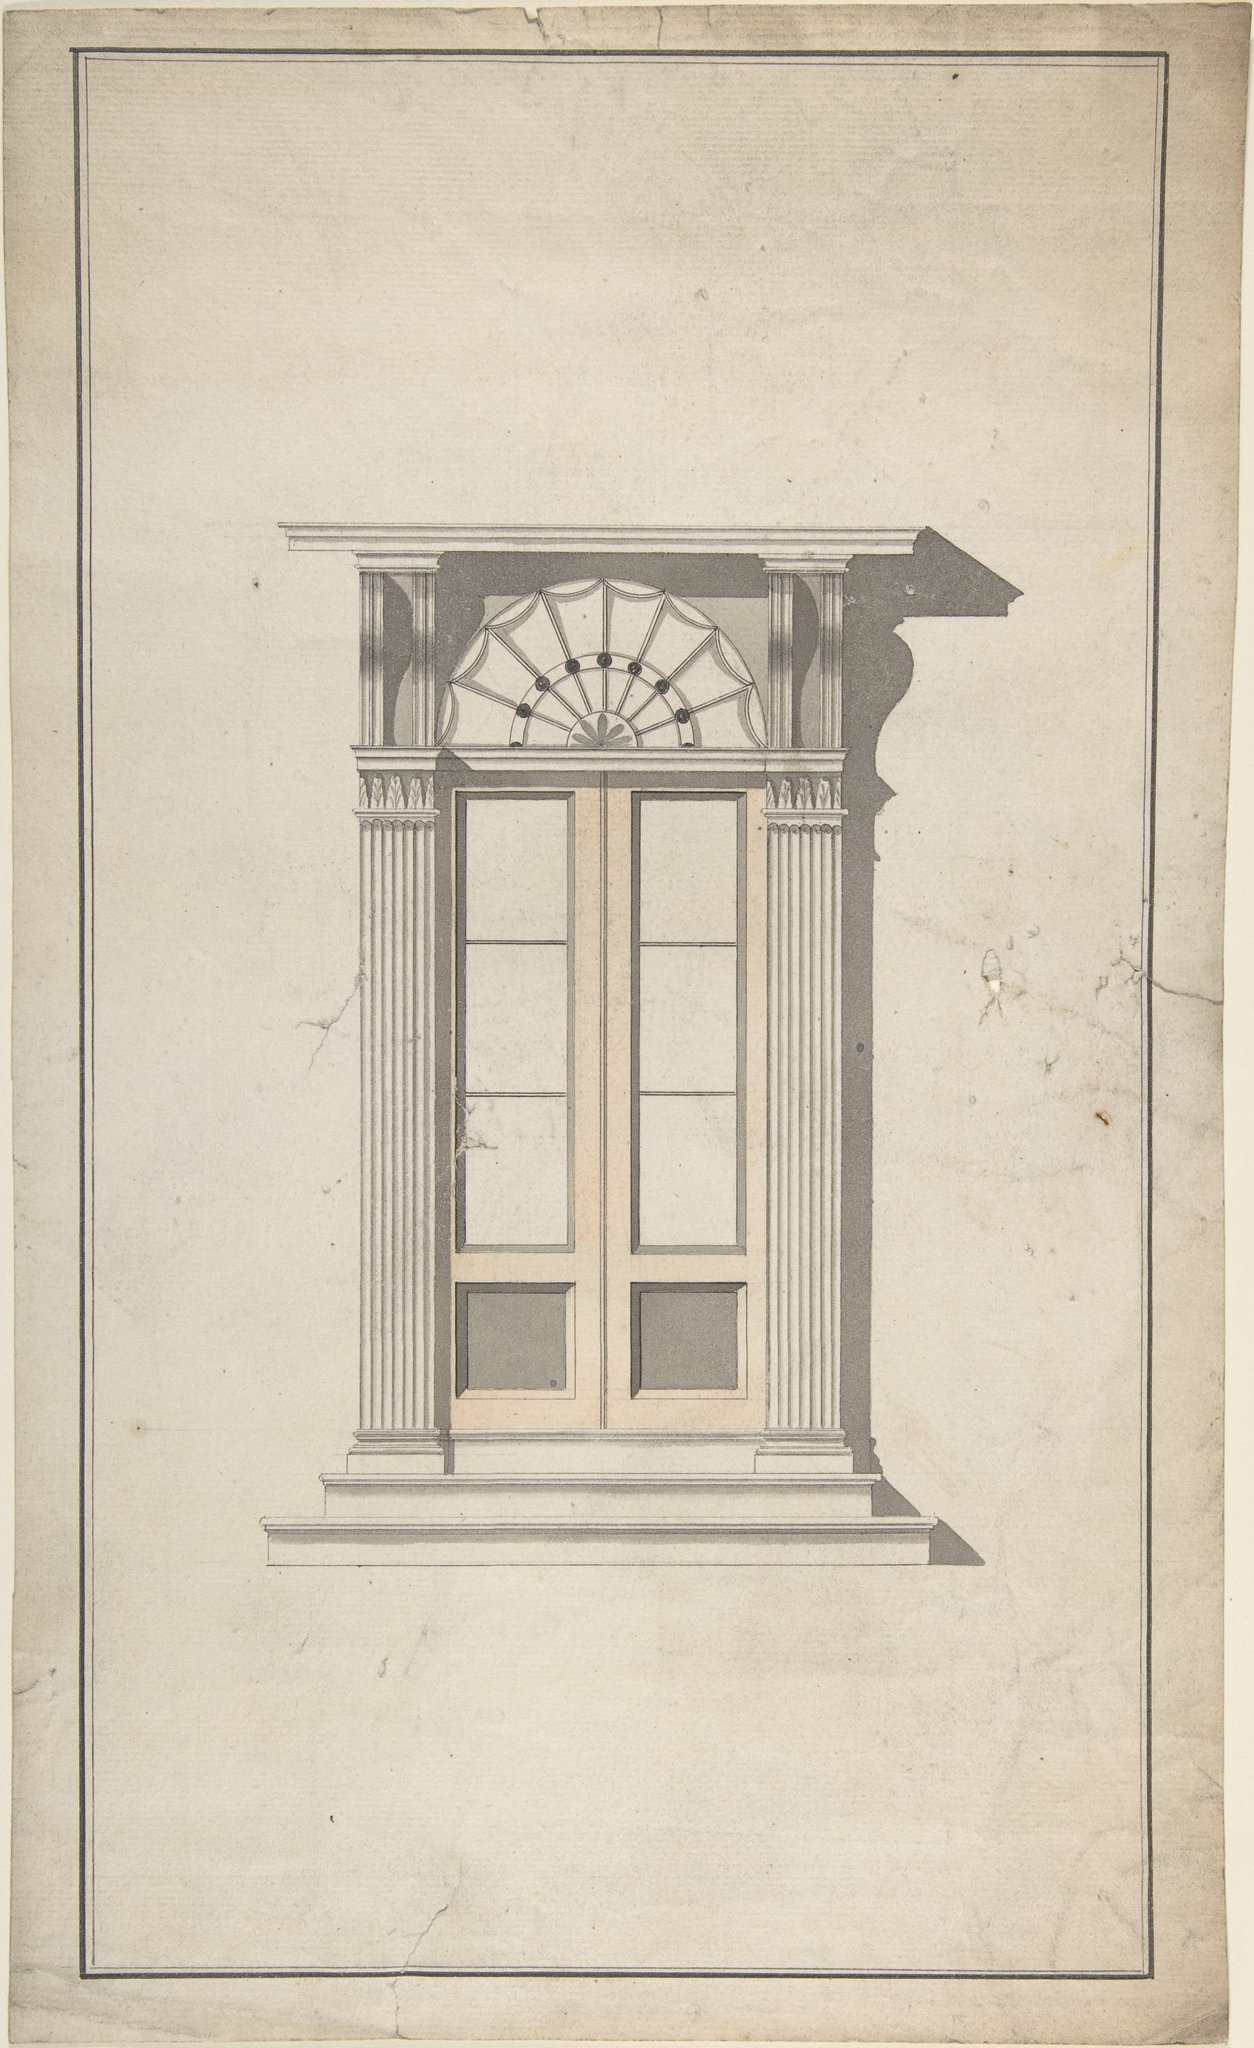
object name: drawing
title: Design for Doorway Exterior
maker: anonymous, french, 18th century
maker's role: artist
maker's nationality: french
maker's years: 1700-1800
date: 1701-1800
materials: ink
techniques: brush, pen, wash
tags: doors